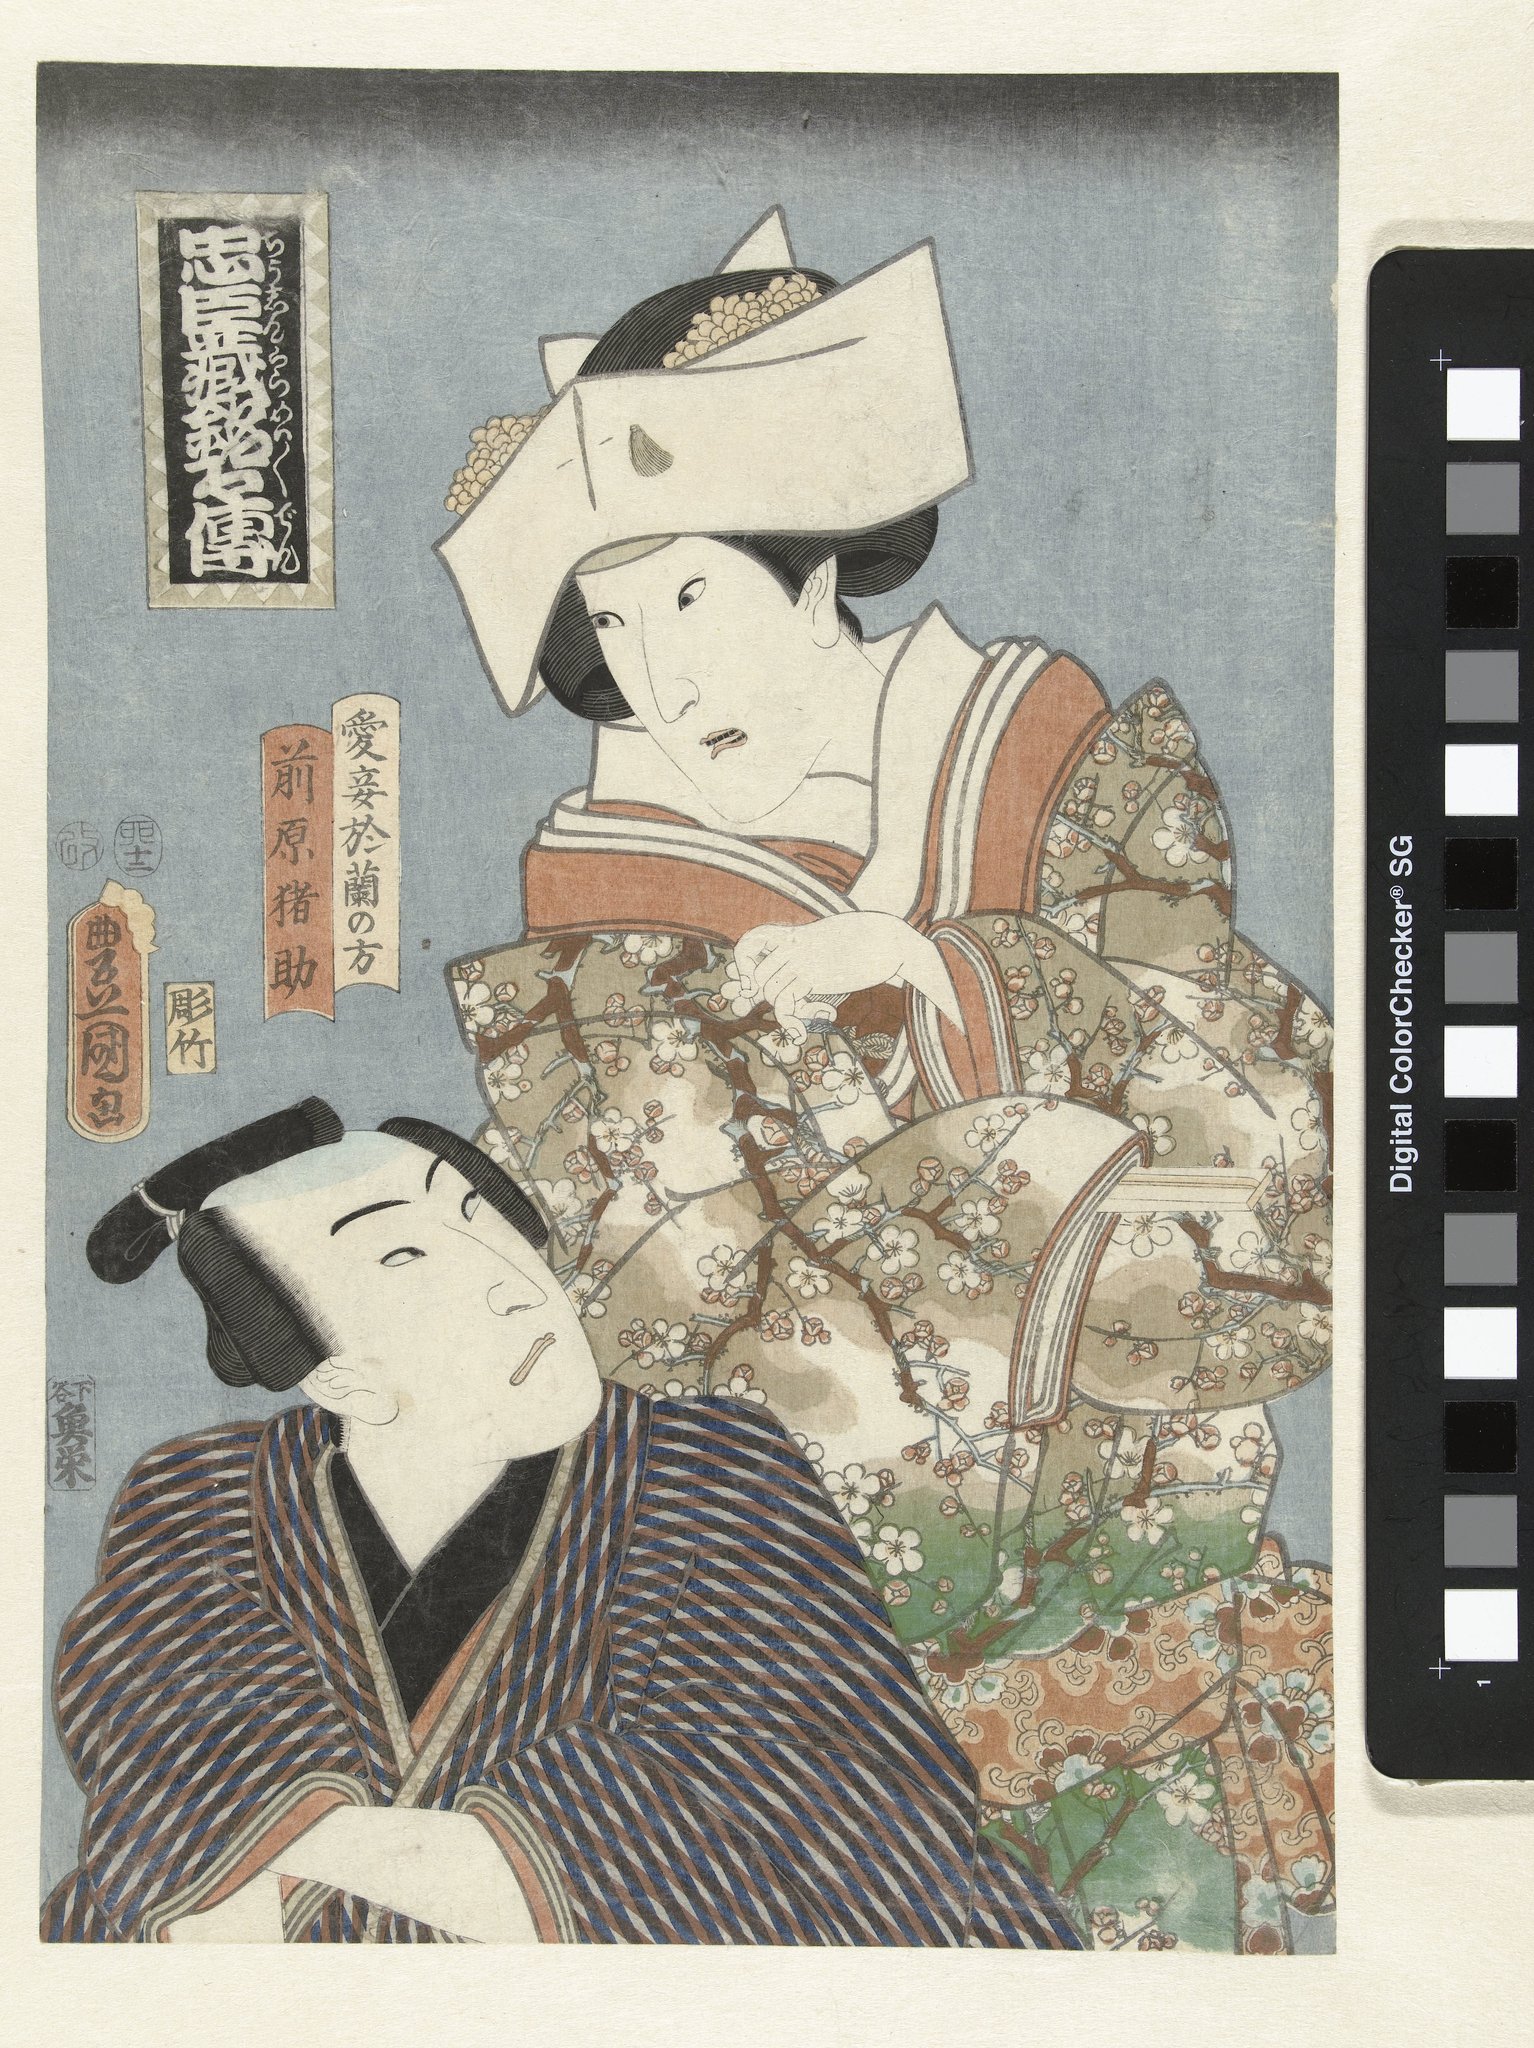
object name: print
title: Chushingura acteurs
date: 1812-1855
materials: paper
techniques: woodcut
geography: japan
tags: portrait of actor, actress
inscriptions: date